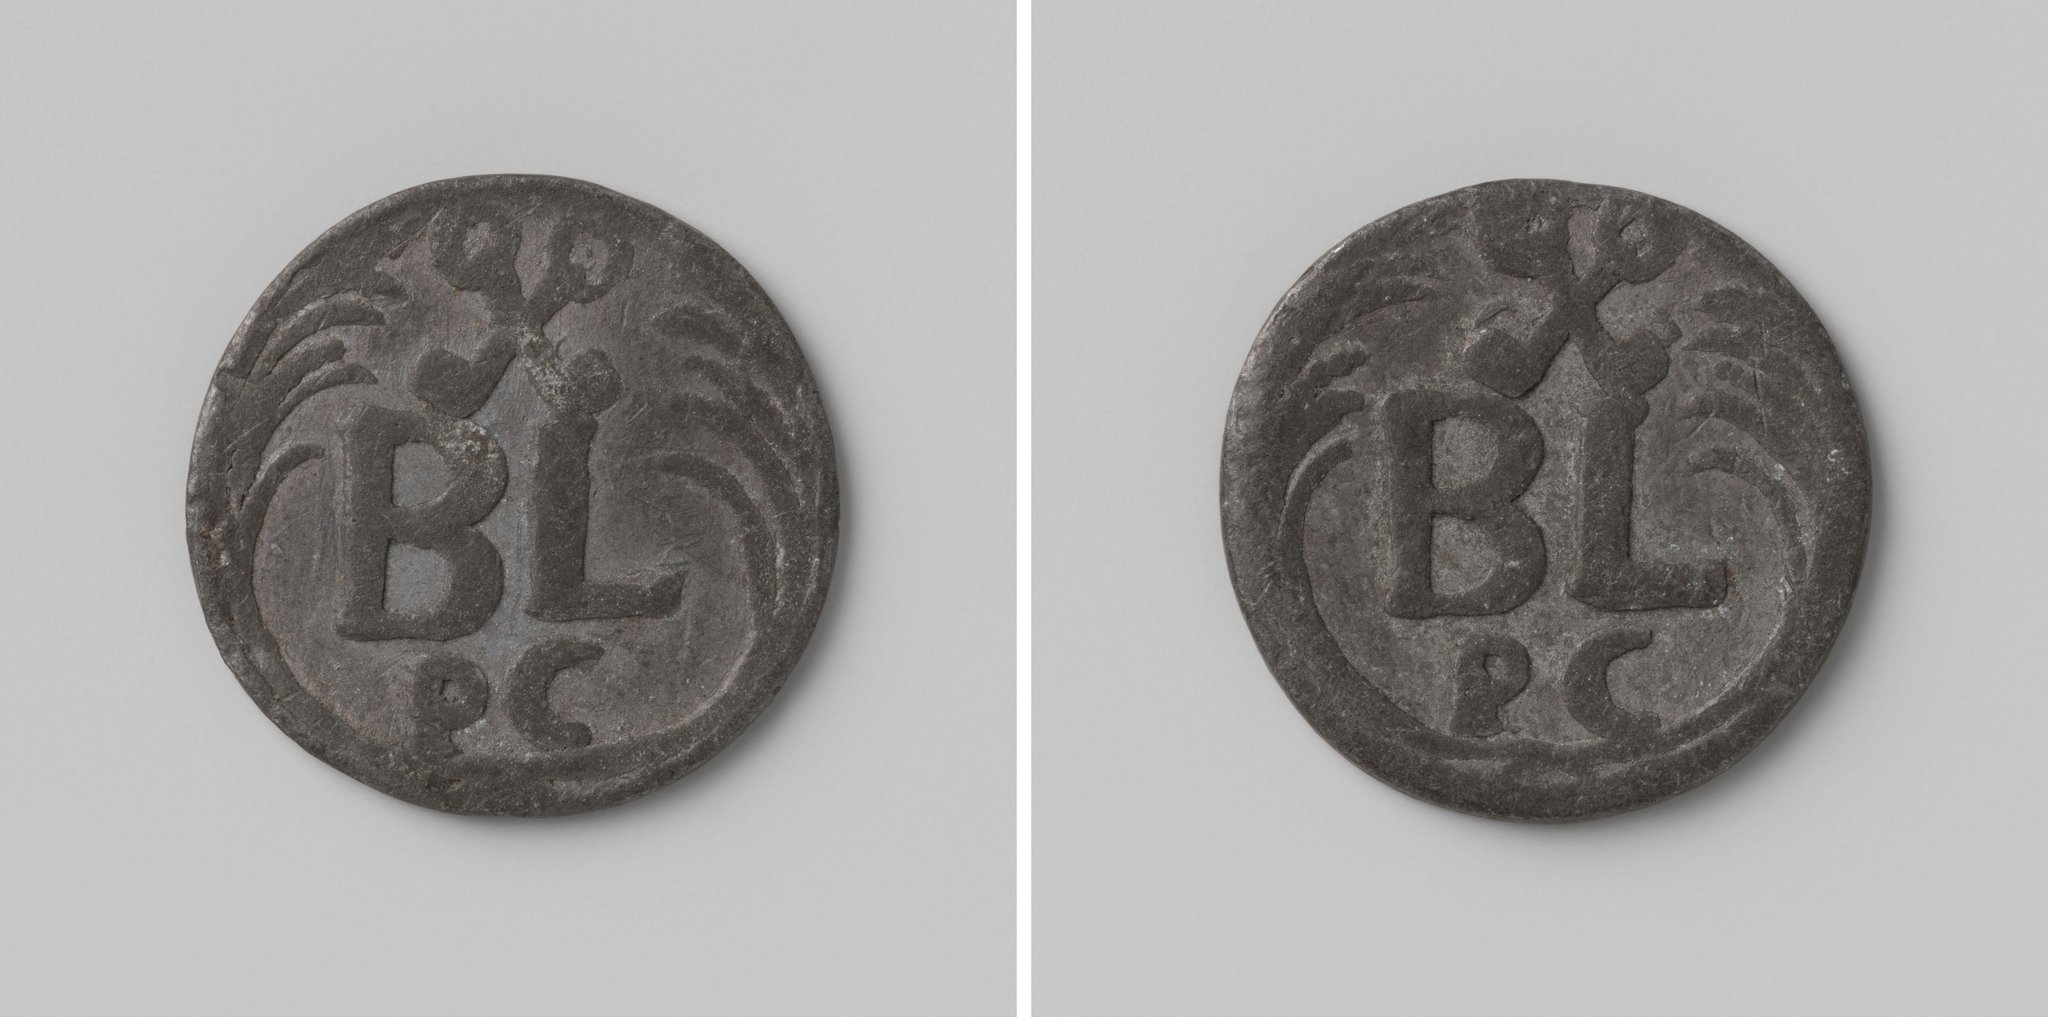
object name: loden penning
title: Kraammoeders te Leiden, loden penning met de opschriften BL en PC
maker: Anonymous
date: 1600-1800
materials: lead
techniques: striking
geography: leiden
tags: leiden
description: Voorzijde: twee gekruiste sleutels onder letters BL en letters PC binnen bladerkrans. Keerzijde: twee gekruiste sleutels onder letters BL en letters PC binnen bladerkrans